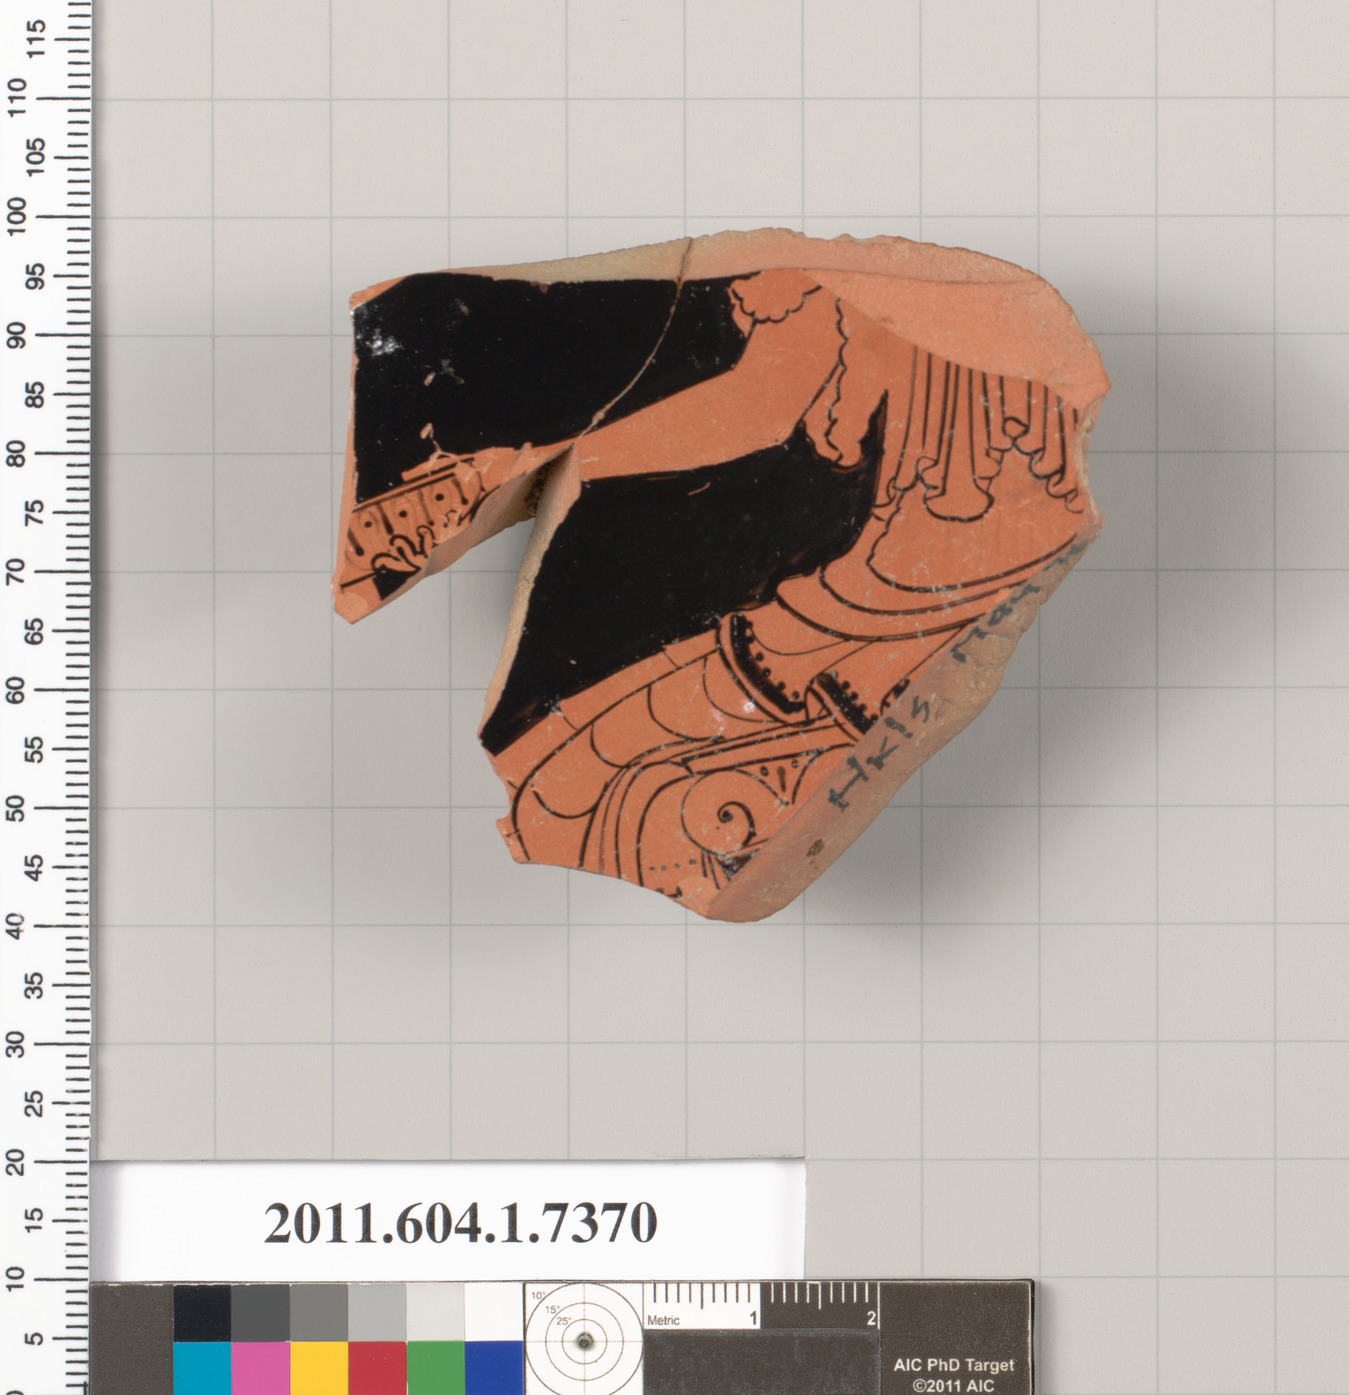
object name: kylix fragment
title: Terracotta fragment of a kylix (drinking cup)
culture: greek, attic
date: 500-480 BCE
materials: terracotta